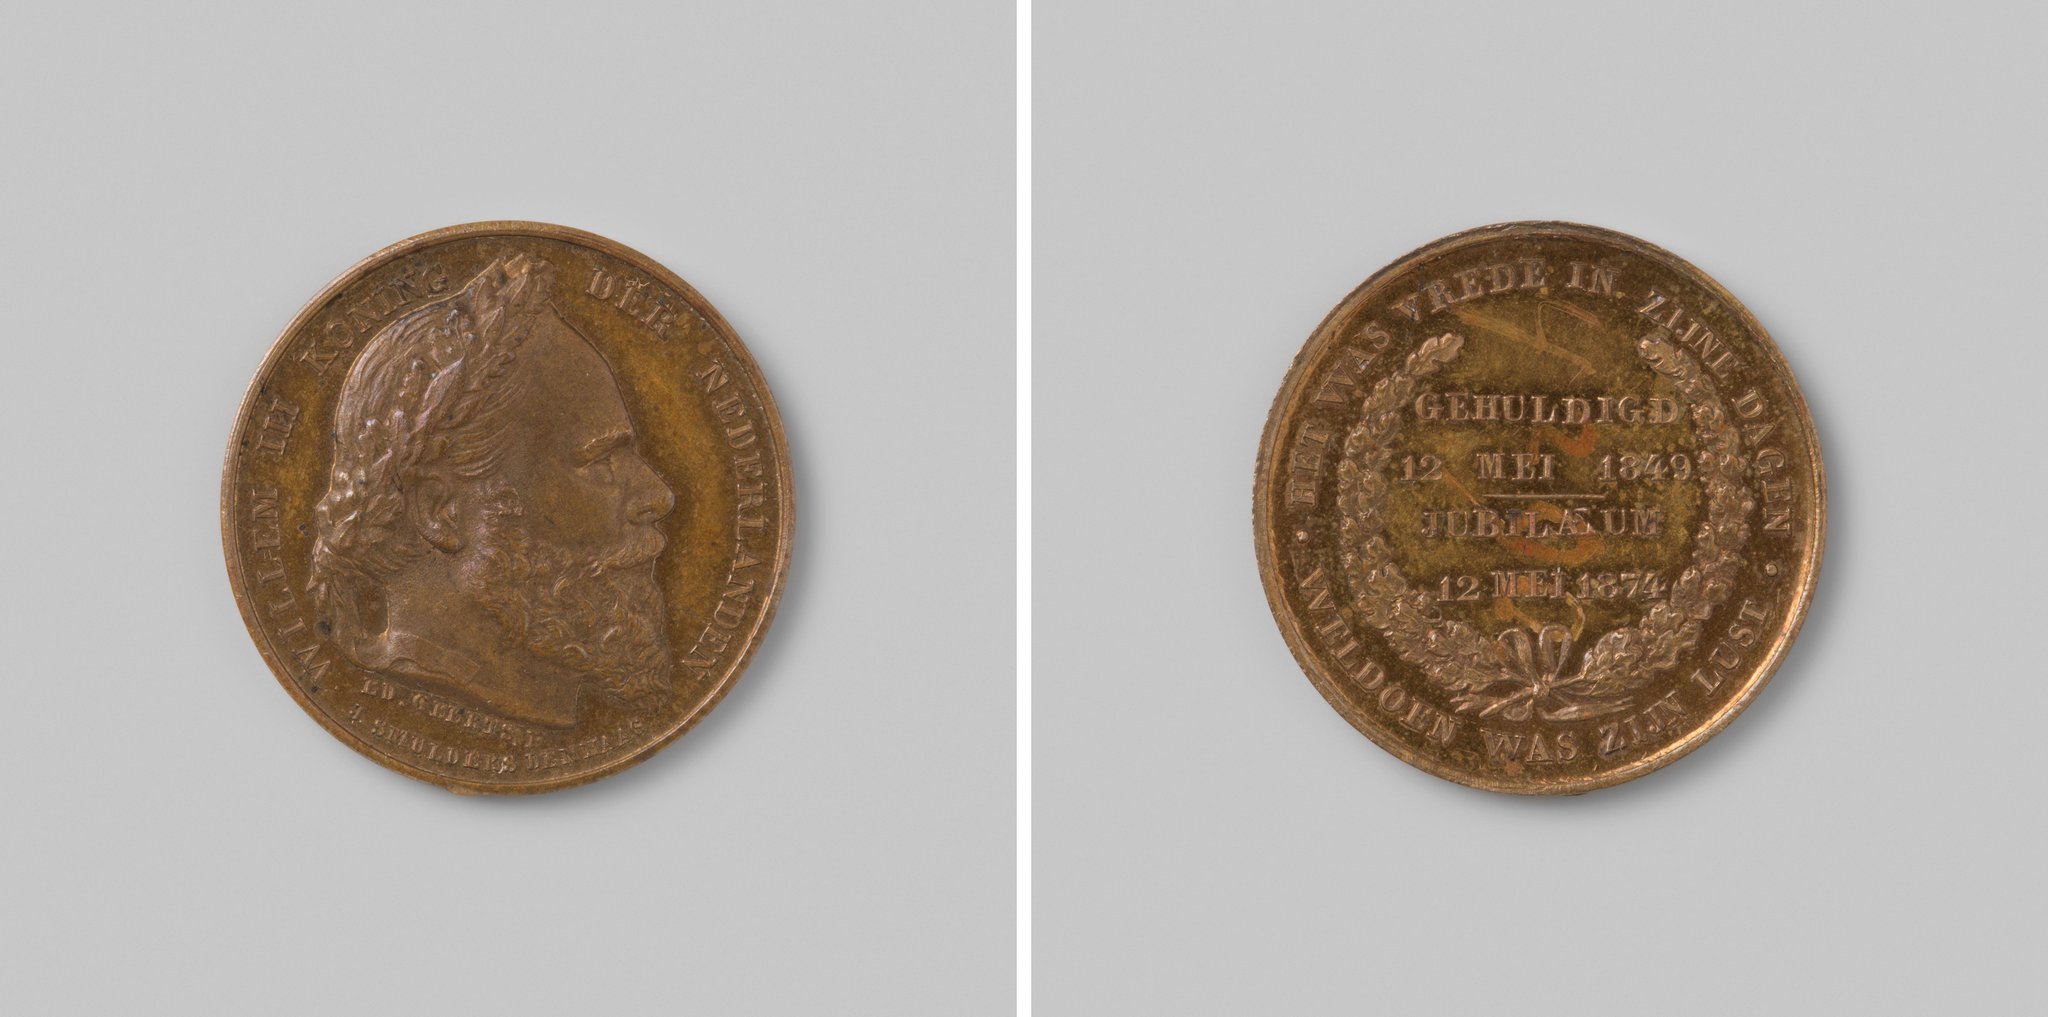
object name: strooipenning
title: Vijfentwintigjarig regeringsjubileum van Willem III, koning der Nederlanden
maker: edouard louis geerts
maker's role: medailleur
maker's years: 1846-1889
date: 1874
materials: copper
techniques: striking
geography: the hague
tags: brussels, willem iii (koning der nederlanden), low countries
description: Koperen penning. Voorzijde: borststuk man met krans van eike- en lauwerbladeren binnen omschrift. Keerzijde: opschrift binnen eikekrans en omschrift.